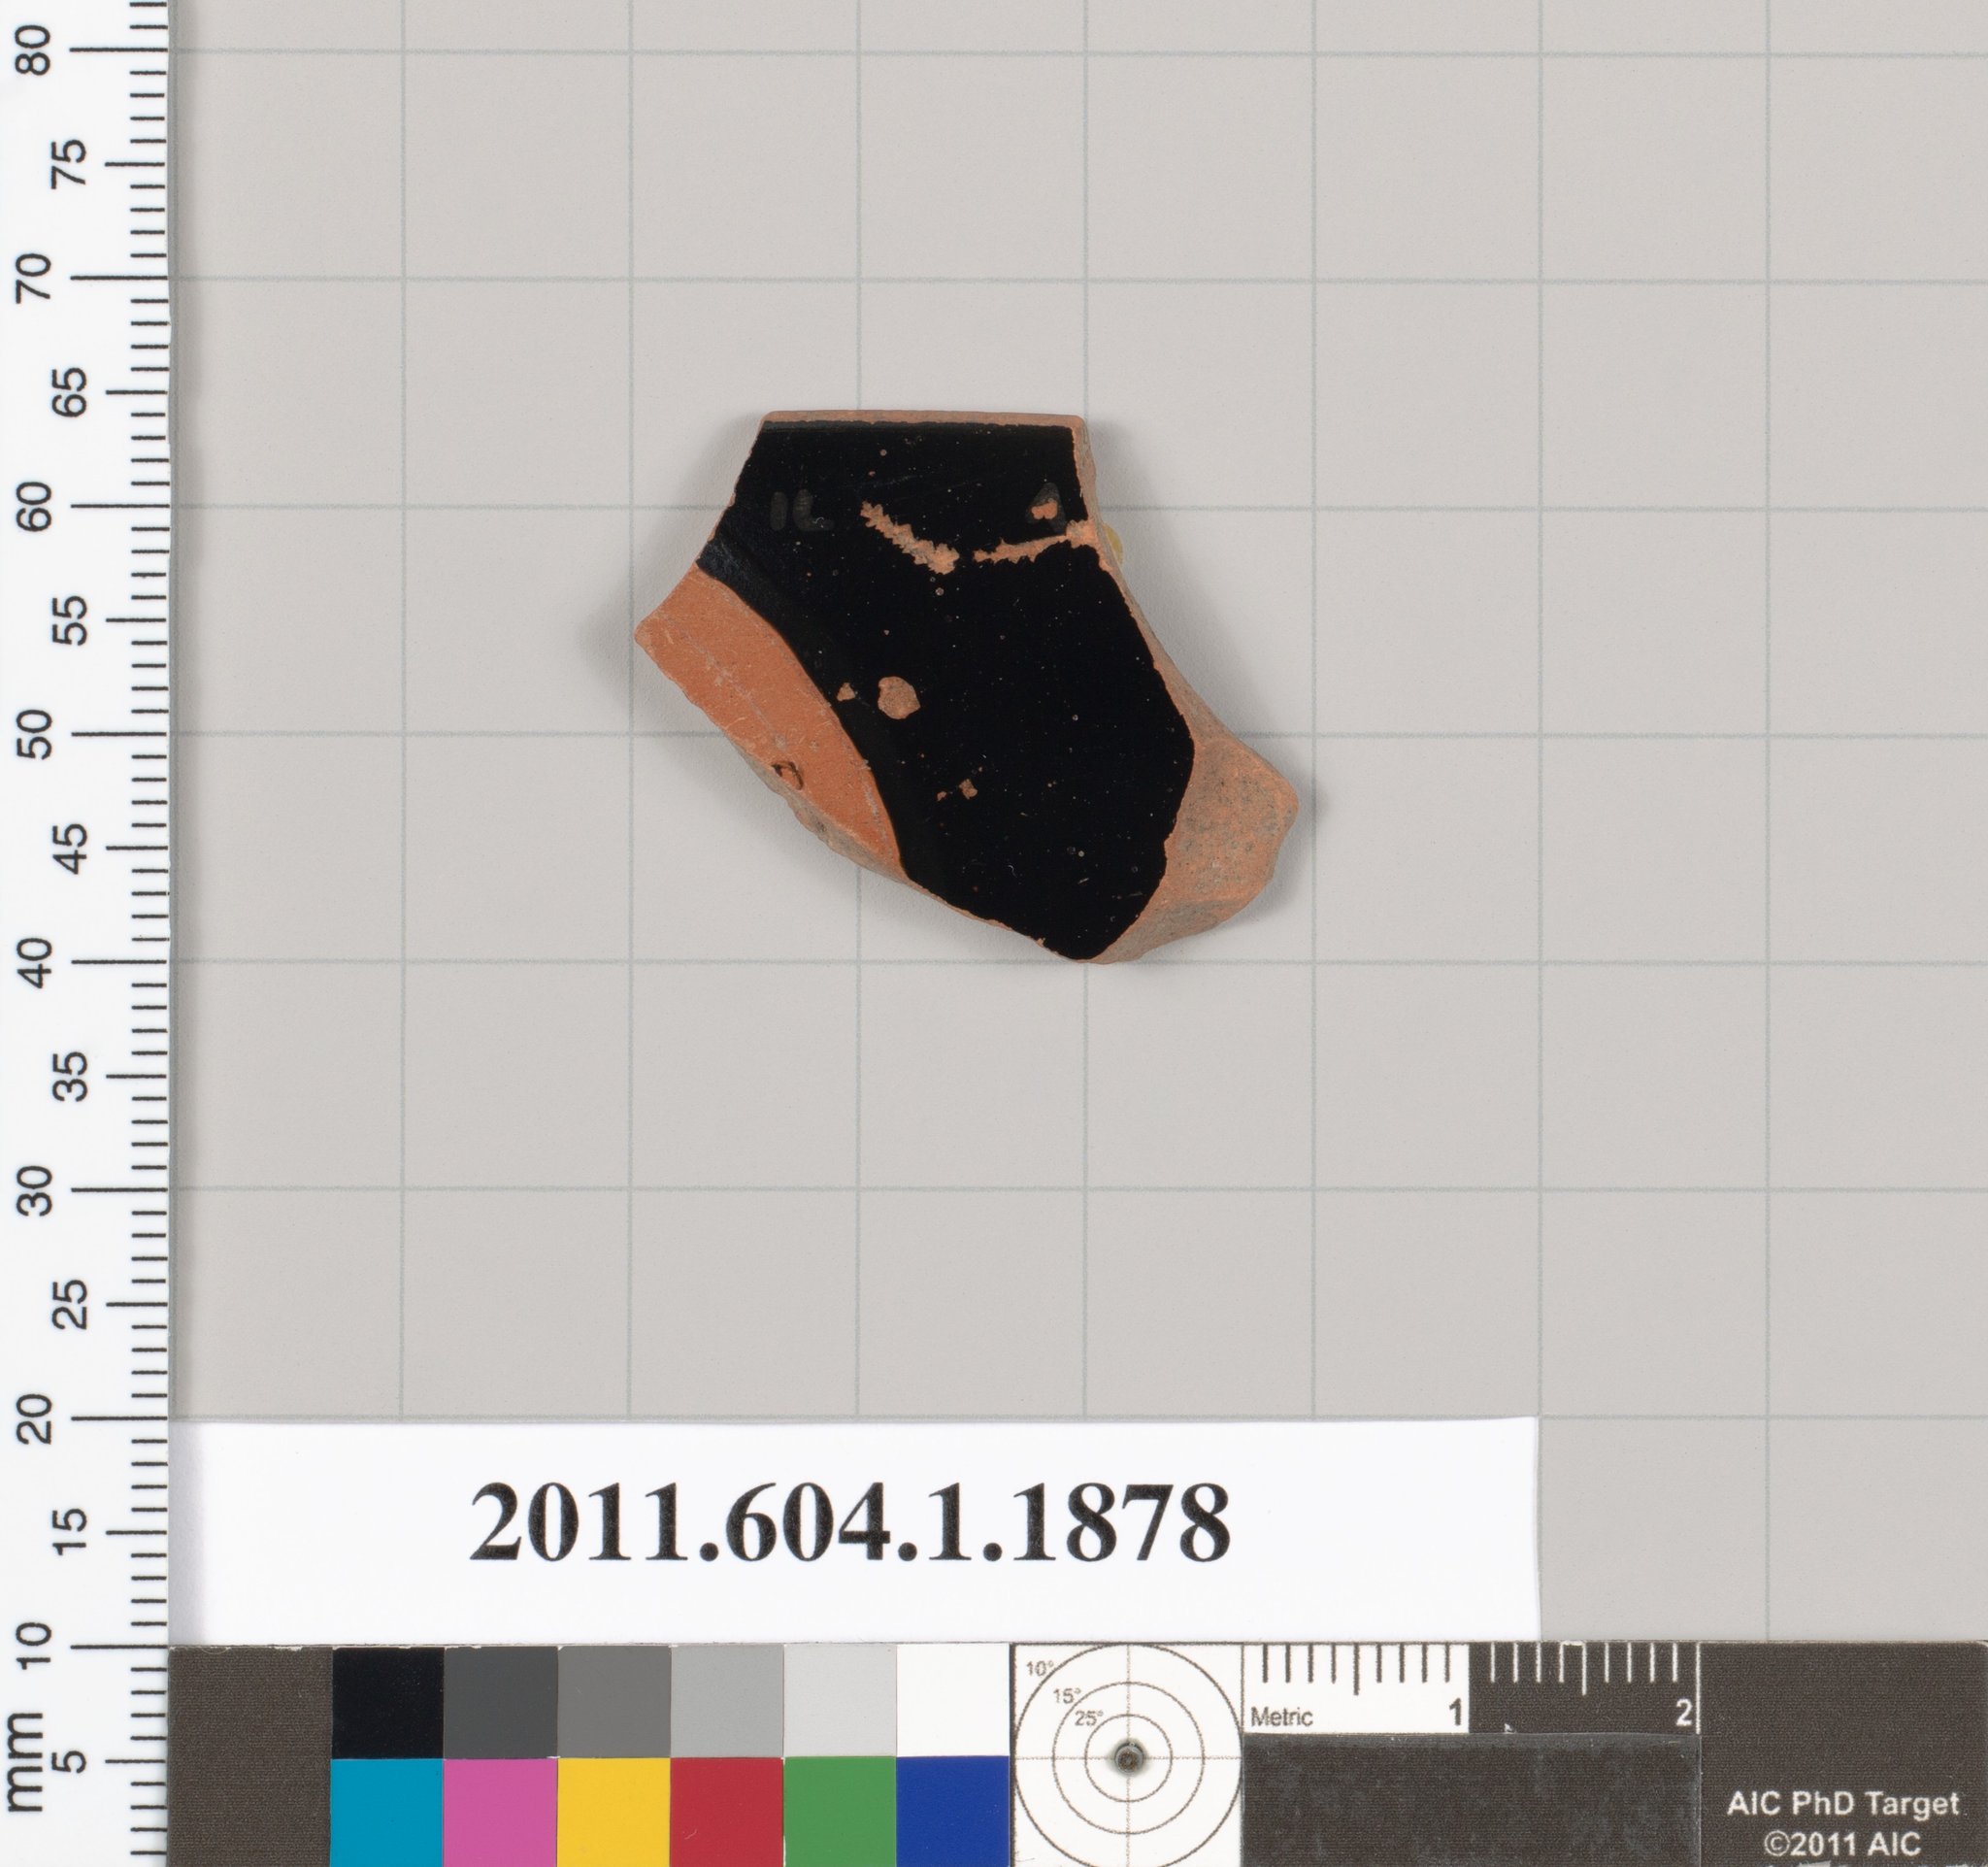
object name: kylix fragment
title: Terracotta rim fragment of a kylix (drinking cup)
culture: greek, attic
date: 475-451 BCE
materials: terracotta